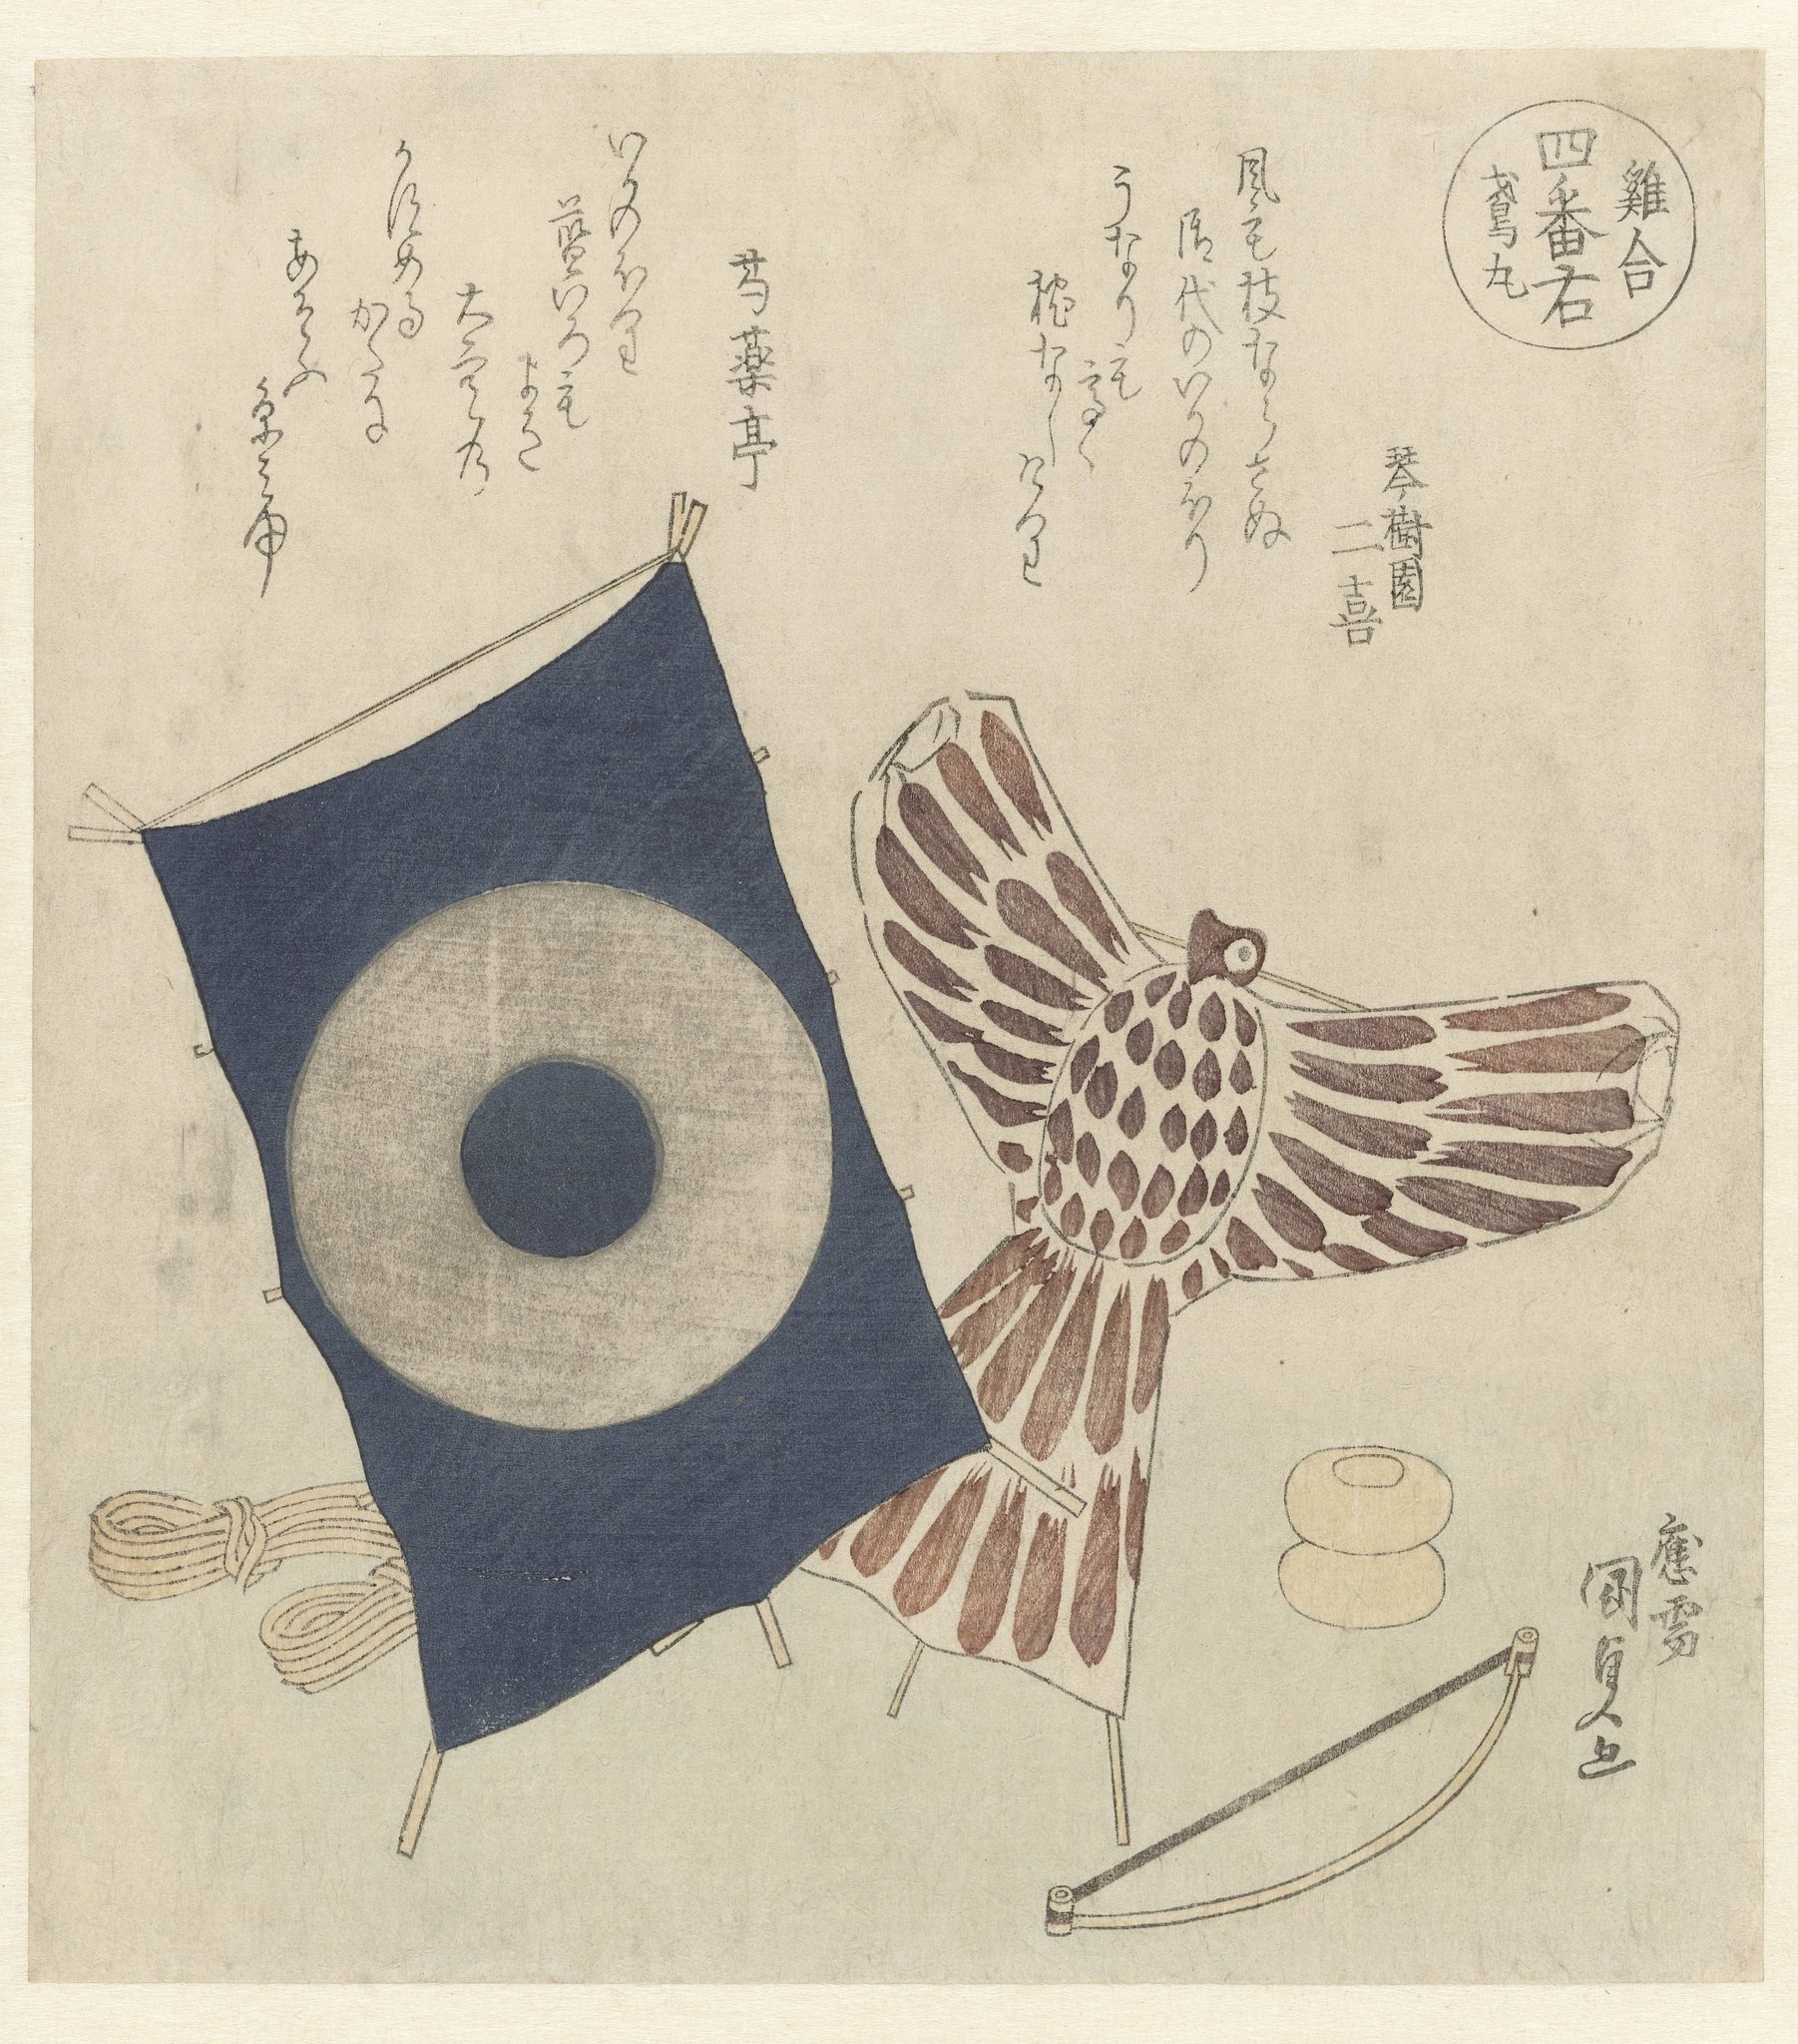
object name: print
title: Two Kites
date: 1825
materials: paper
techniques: blind stamped, woodcut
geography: japan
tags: (flying a) kite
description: Een surimono is een luxe uitgevoerde prent waarop beeld met één of meerdere gedichten gecombineerd is. Bij het drukken van een surimono werd vaak gebruik gemaakt van dikker papier, blinddruk en metaal pigmenten, zoals koper- en zilverpoeder. De prenten werden vaak in opdracht van dichters gemaakt en als exclusief geschenk aan vrienden en relaties gegeven.